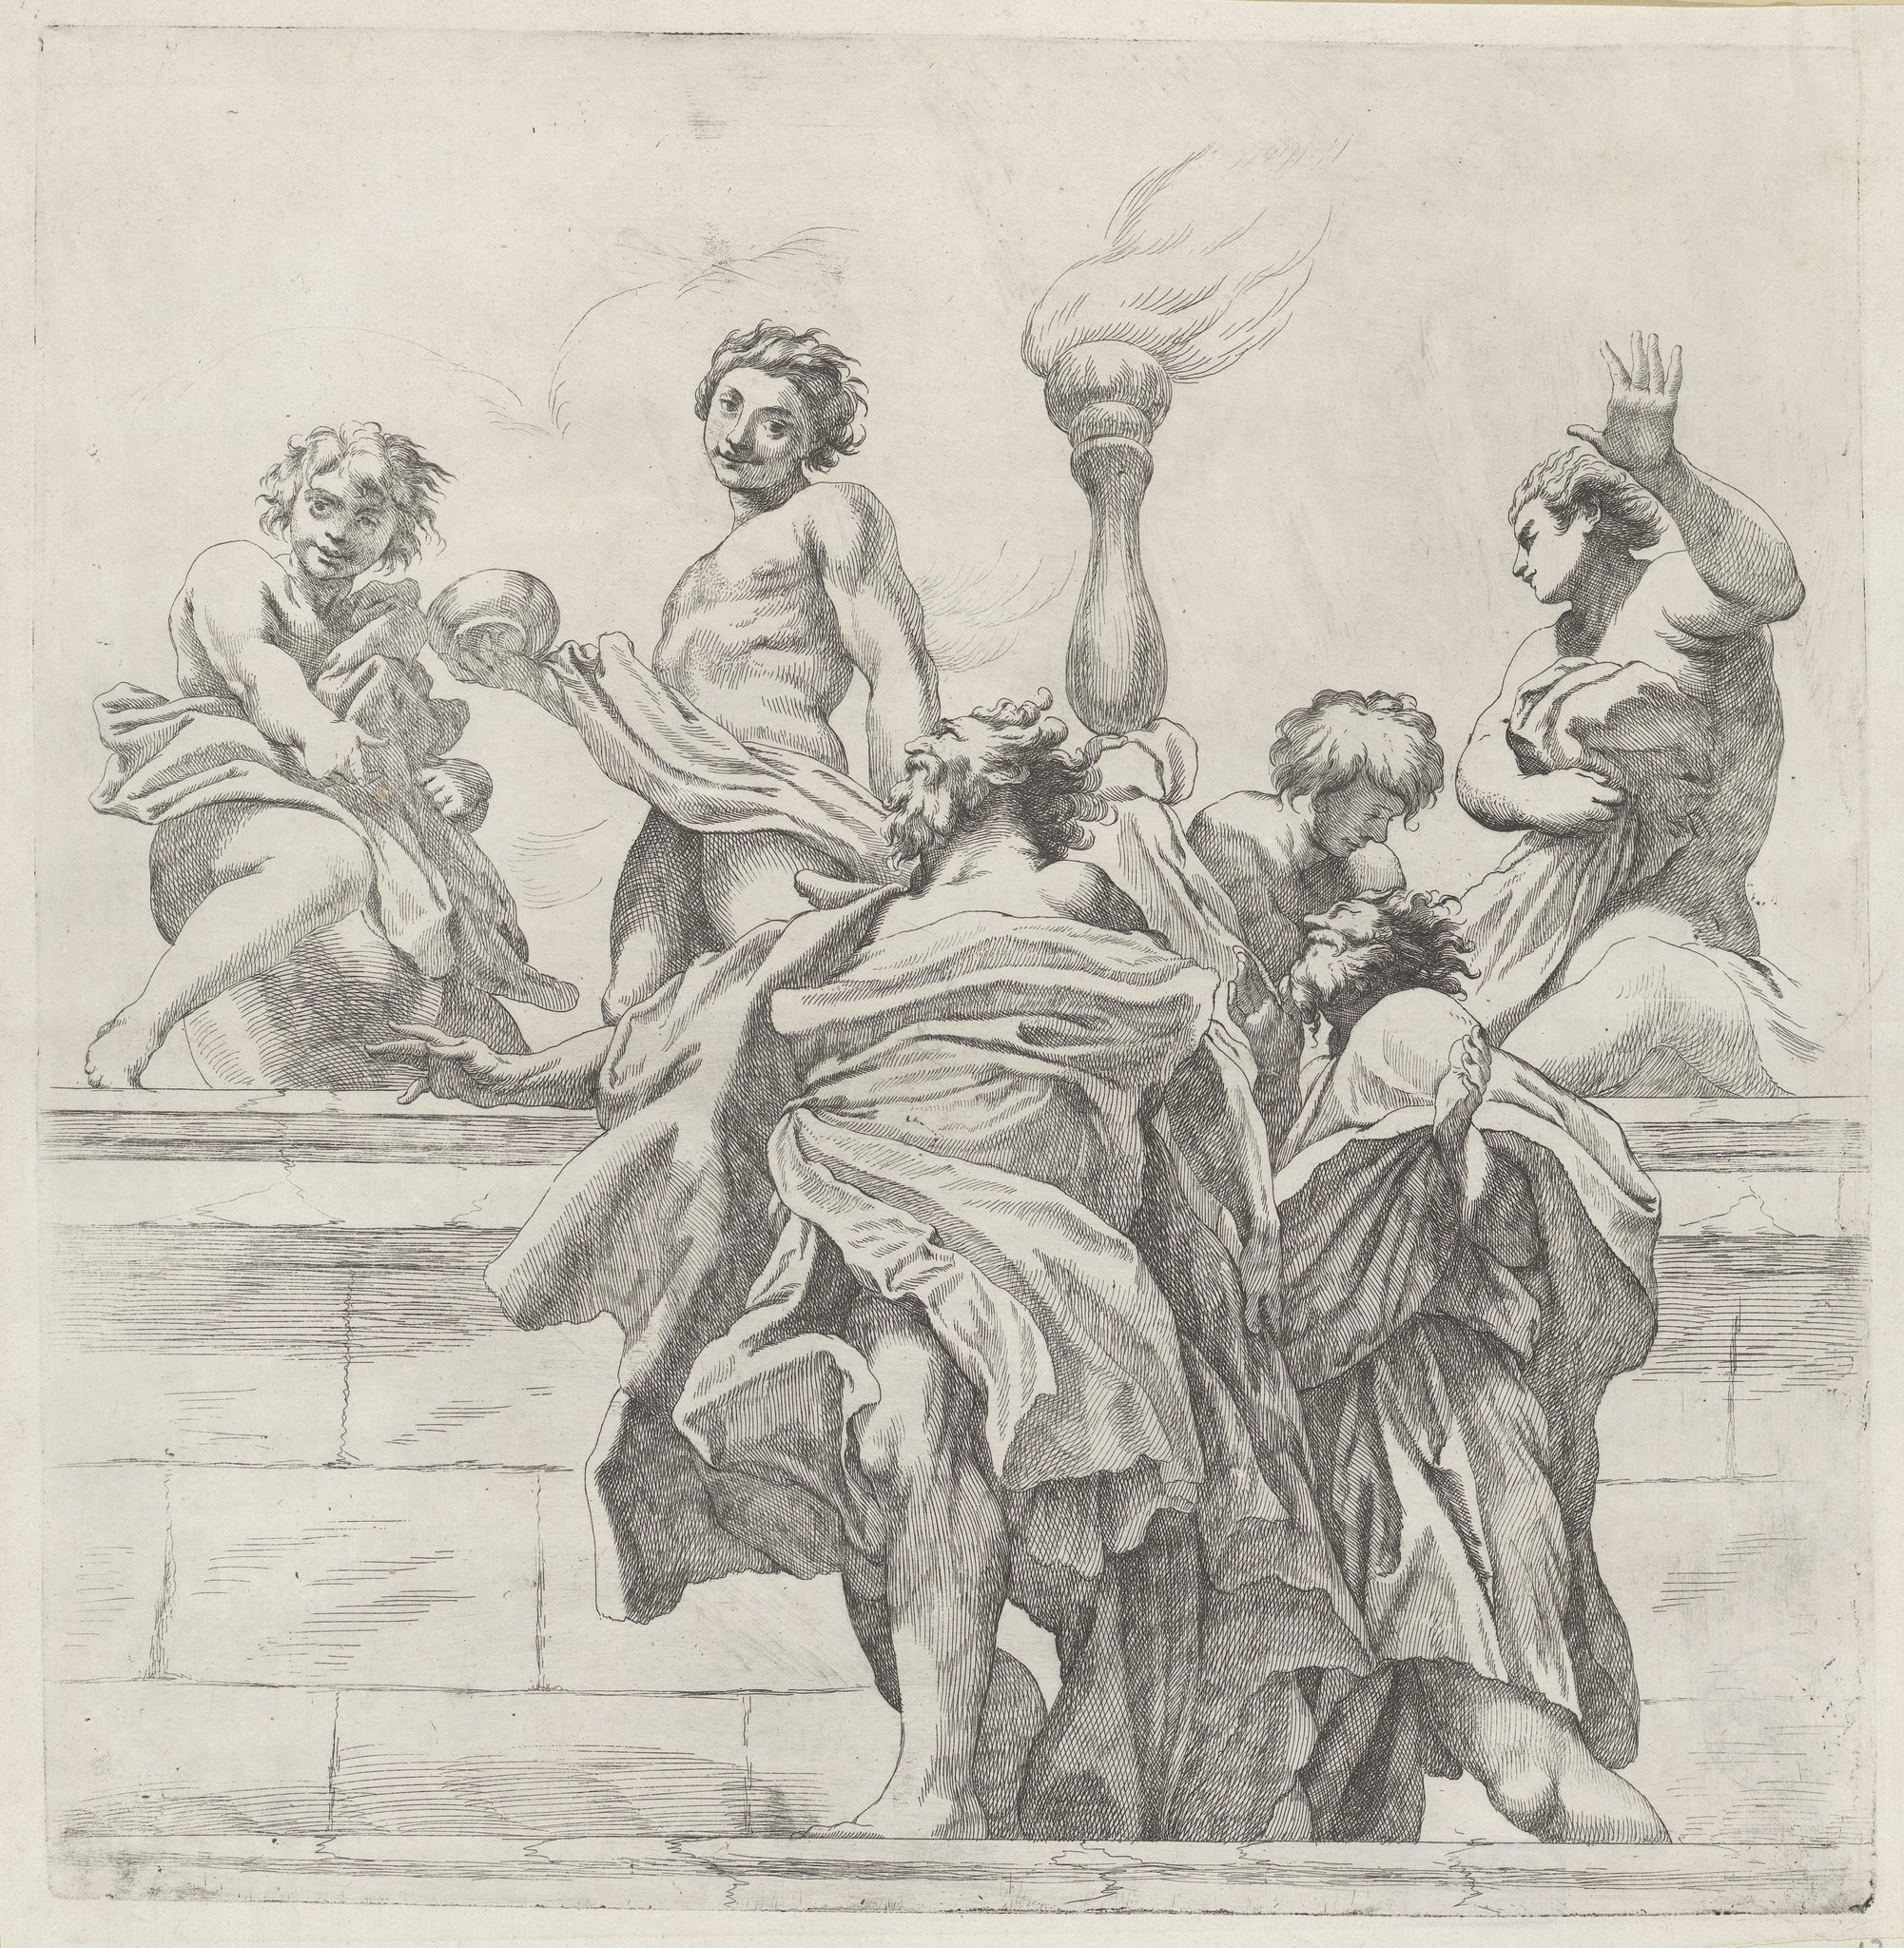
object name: print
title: Koepeldecoraties door Correggio in de S. Giovanni Evangelista in Parma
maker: giovanni battista vanni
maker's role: print maker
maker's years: 1599-1660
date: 1609-1660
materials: paper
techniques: etching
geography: parma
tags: (single) apostle, unspecified, angels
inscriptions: collector's mark: Lugt 11, collector's mark: Lugt 10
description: Prent uit een reeks van 8 prenten naar de koepeldecoraties door Correggio in de S. Giovanni Evangelista in Parma.